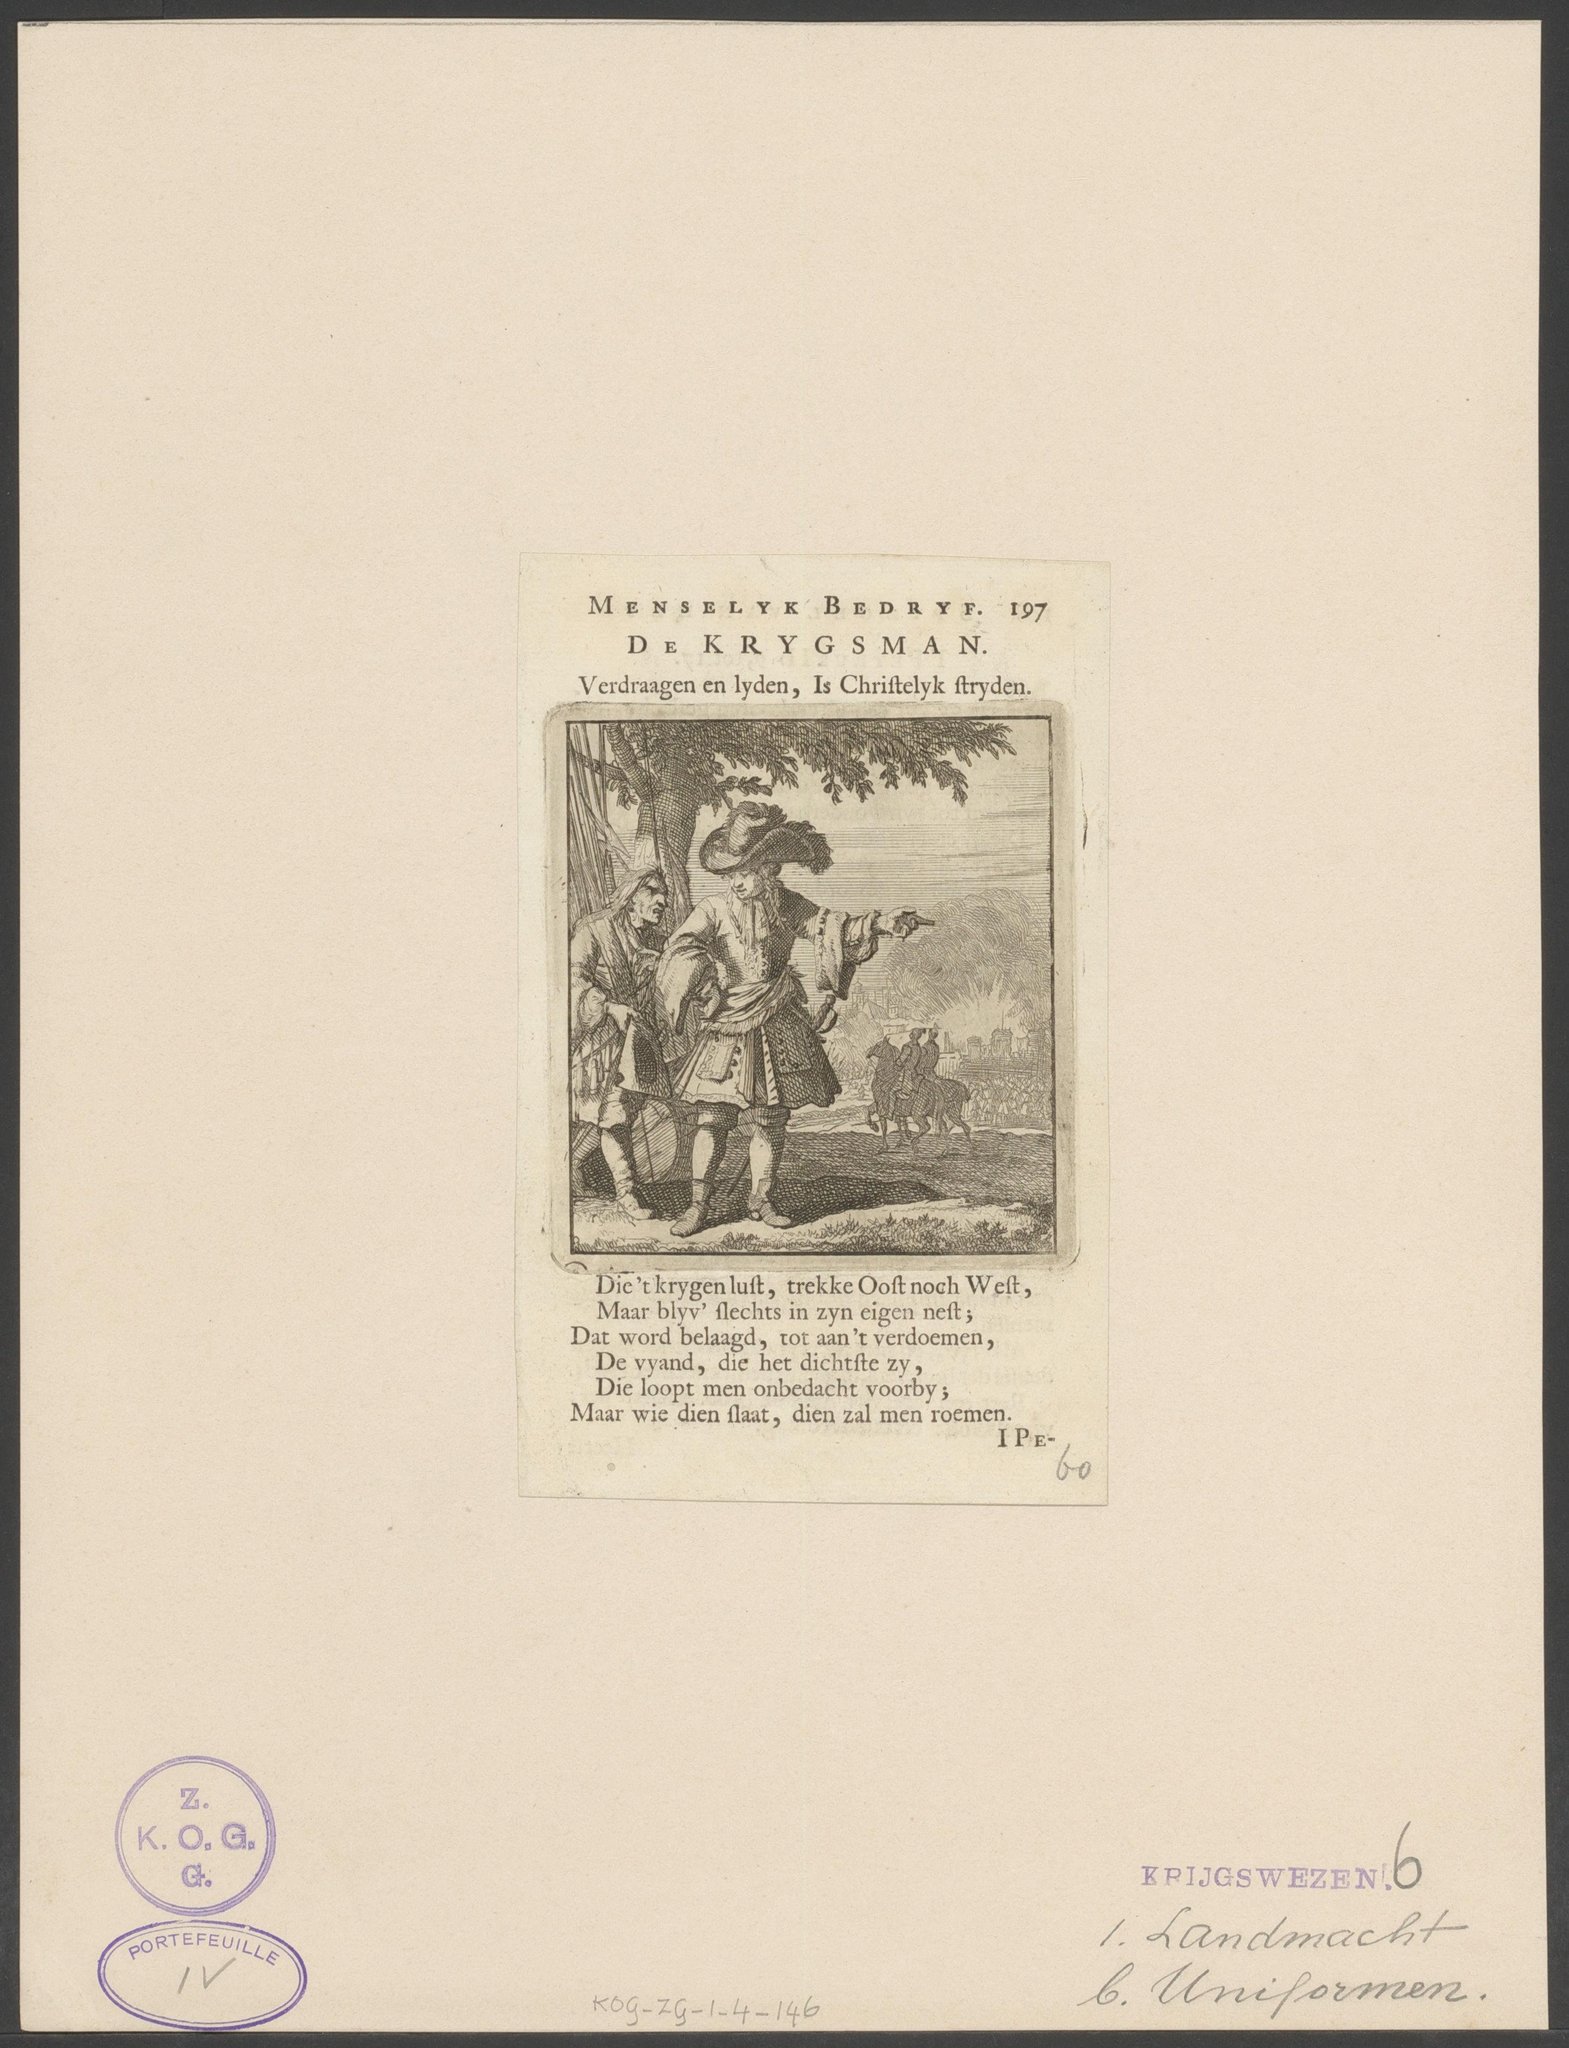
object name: book illustration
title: Het Menselyk Bedryf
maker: jan luyken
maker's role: draughtsman, print maker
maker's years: 1649-1712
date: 1694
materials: paper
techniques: engraving, etching, letterpress printing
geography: netherlands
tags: officer, (military) uniforms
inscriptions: collector's mark, collector's mark: Lugt 1641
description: Blad genomen uit een editie van: Spiegel van het menselyk bedryf, vertoonende honderd verscheiden ambachten, konstig afgebeeld en met godlyke spreuken en stichtelyke verzen verrykt / door Jan en Kasper Luiken. Eerst uitgegeven te Amsterdam in 1694.